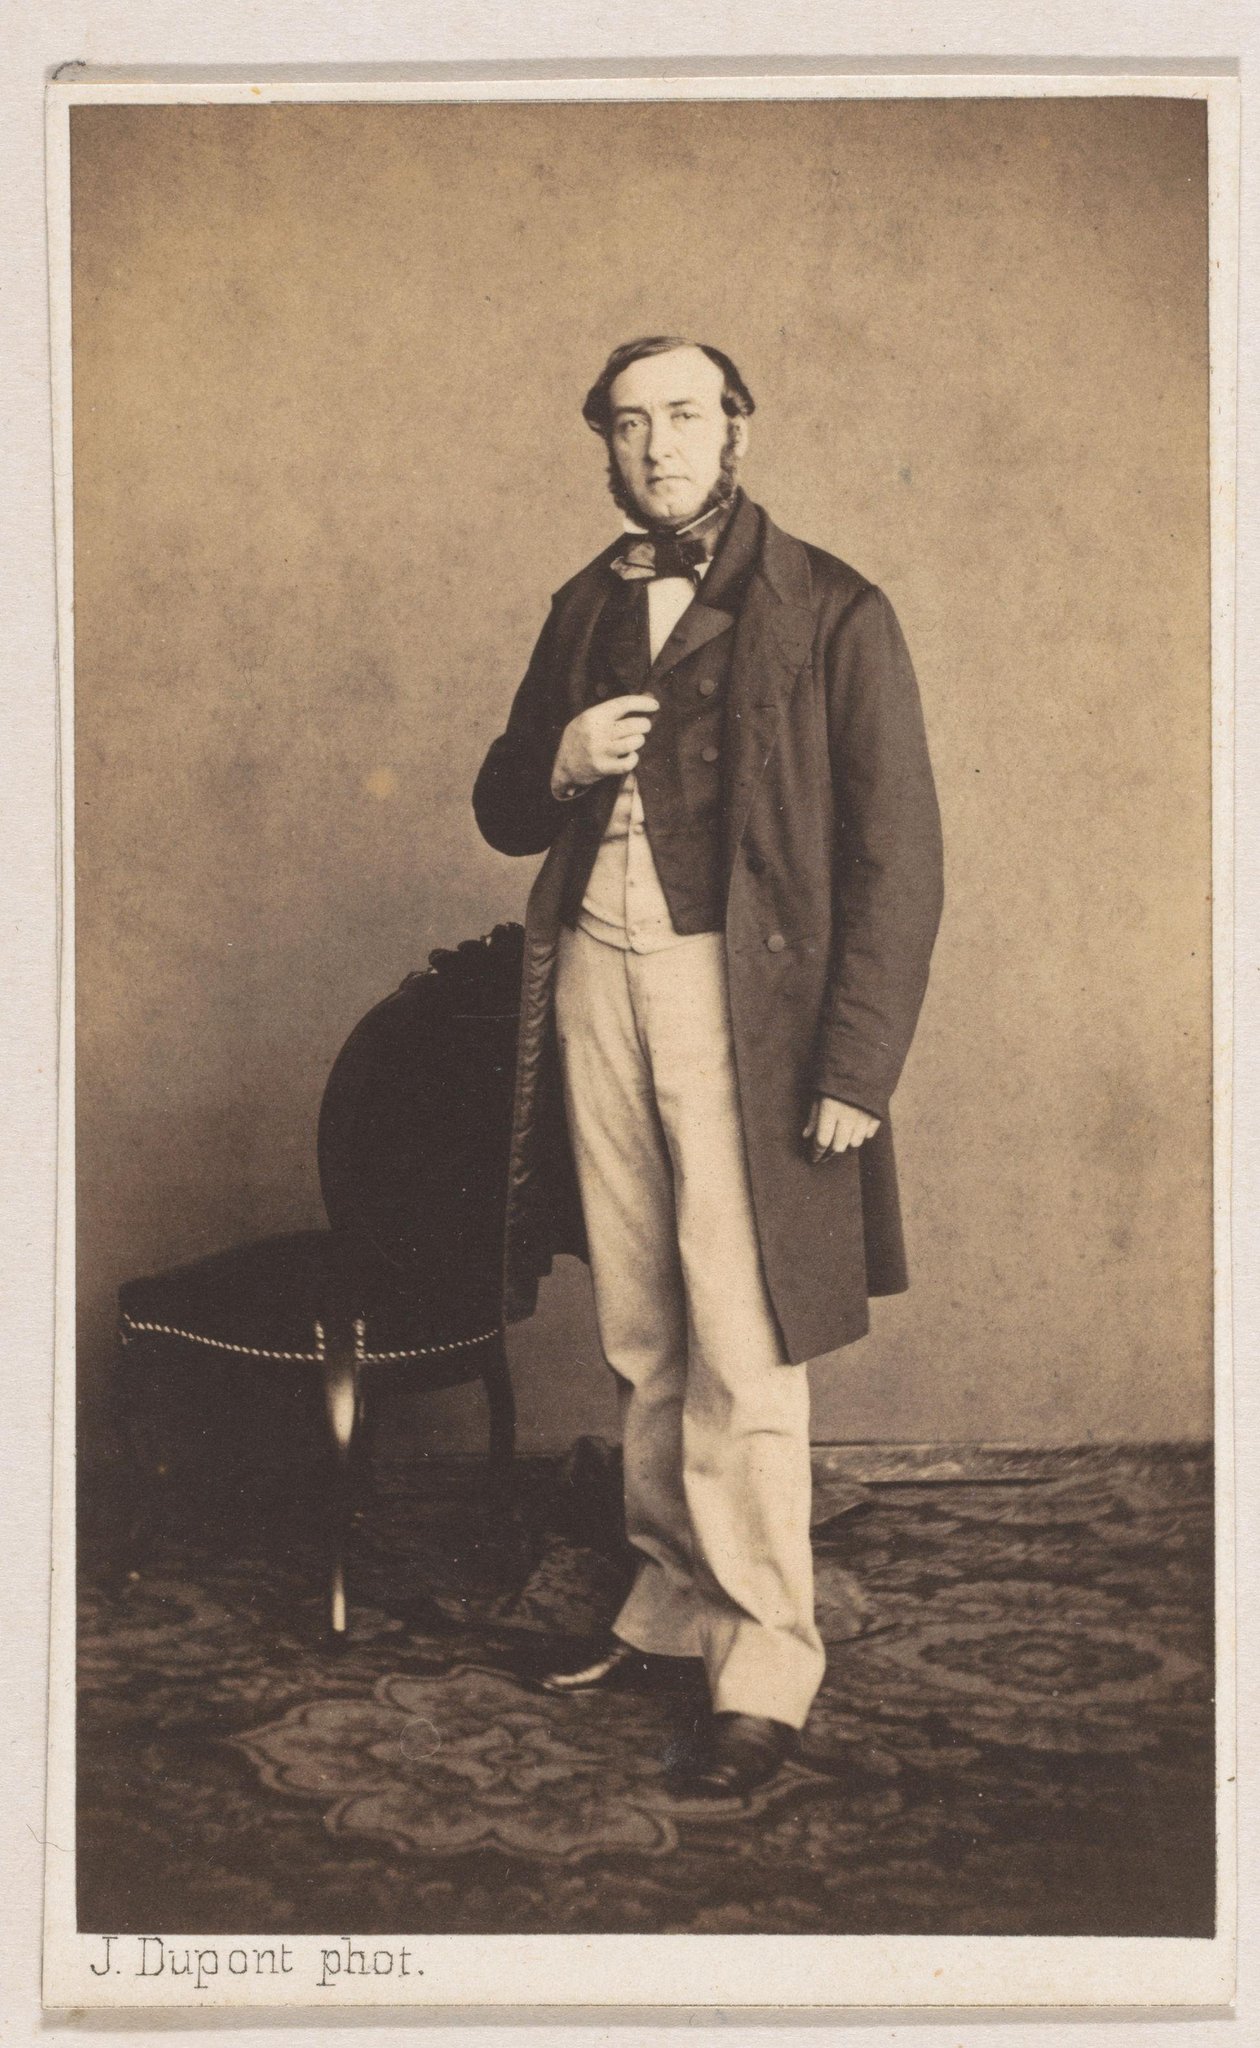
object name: photograph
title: Portret van de schilder Louis Somers, ten voeten uit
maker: joseph dupont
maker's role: fotograaf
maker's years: 1818-1901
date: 1861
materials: cardboard, paper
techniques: albumen print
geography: antwerp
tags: antwerp, draughtsman, louis jean somers, historical persons, portrait, self-portrait of painter, portrait, self-portrait of artist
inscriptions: inscription: ‘ETABLISSEMENT PHOTOGRAPHIQUE/ de/ J. DUPONT/ Place de Meir 32/ ANVERS/ Maison fondée en 1853’